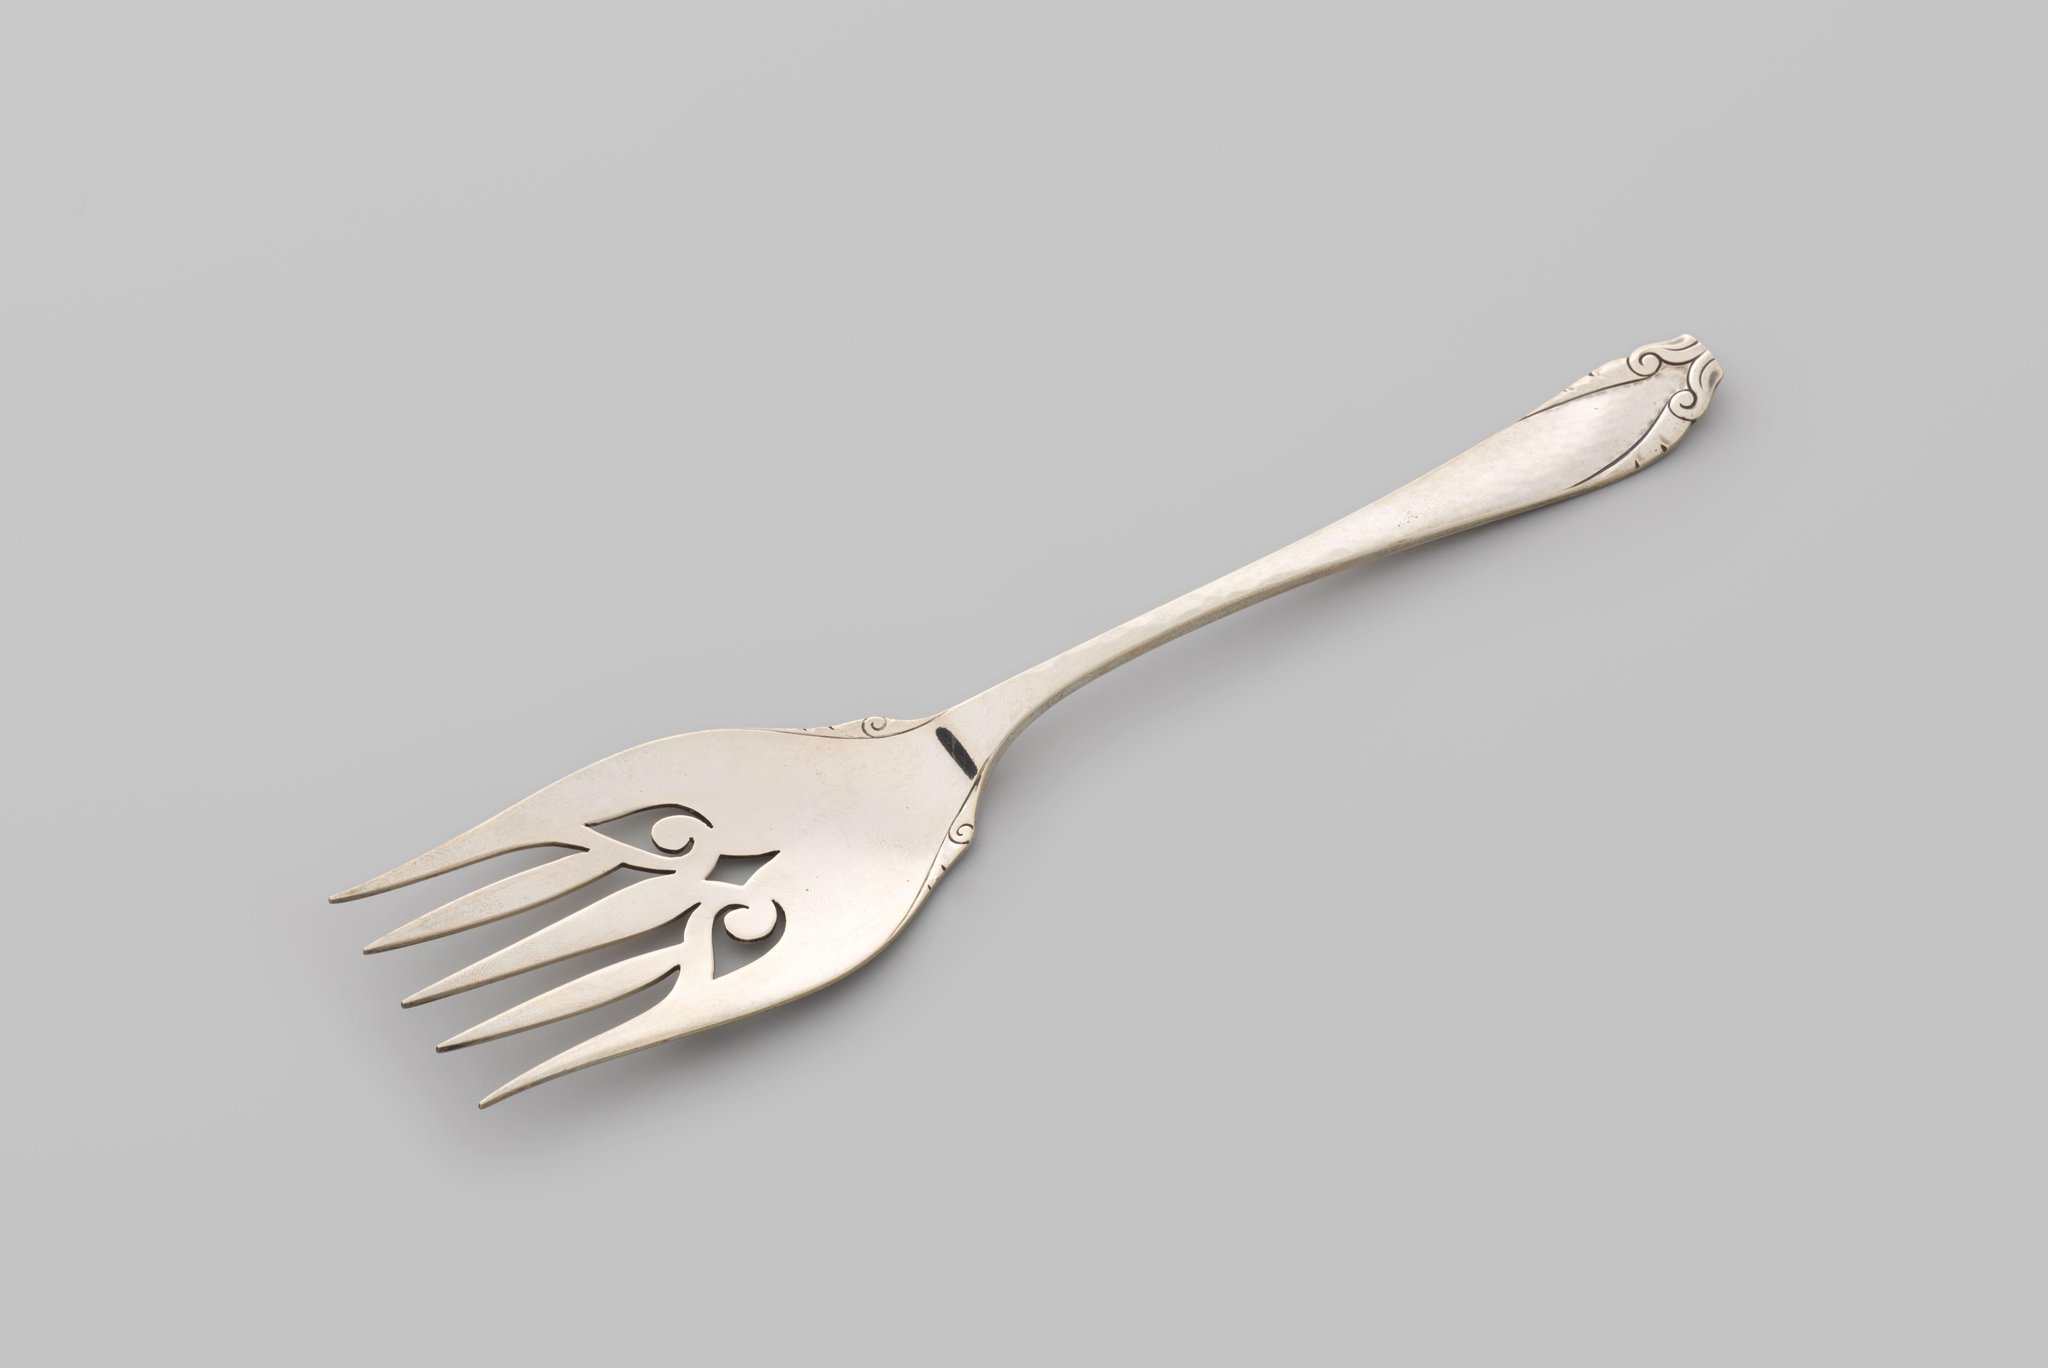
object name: fork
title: Taartvork van zilver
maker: harm ellens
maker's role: print maker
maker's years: 1871-1939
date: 1929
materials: silver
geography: schoonhoven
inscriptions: mark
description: De platte vijftandige vork heeft een opengewerkte versiering van vlamachtige motieven.